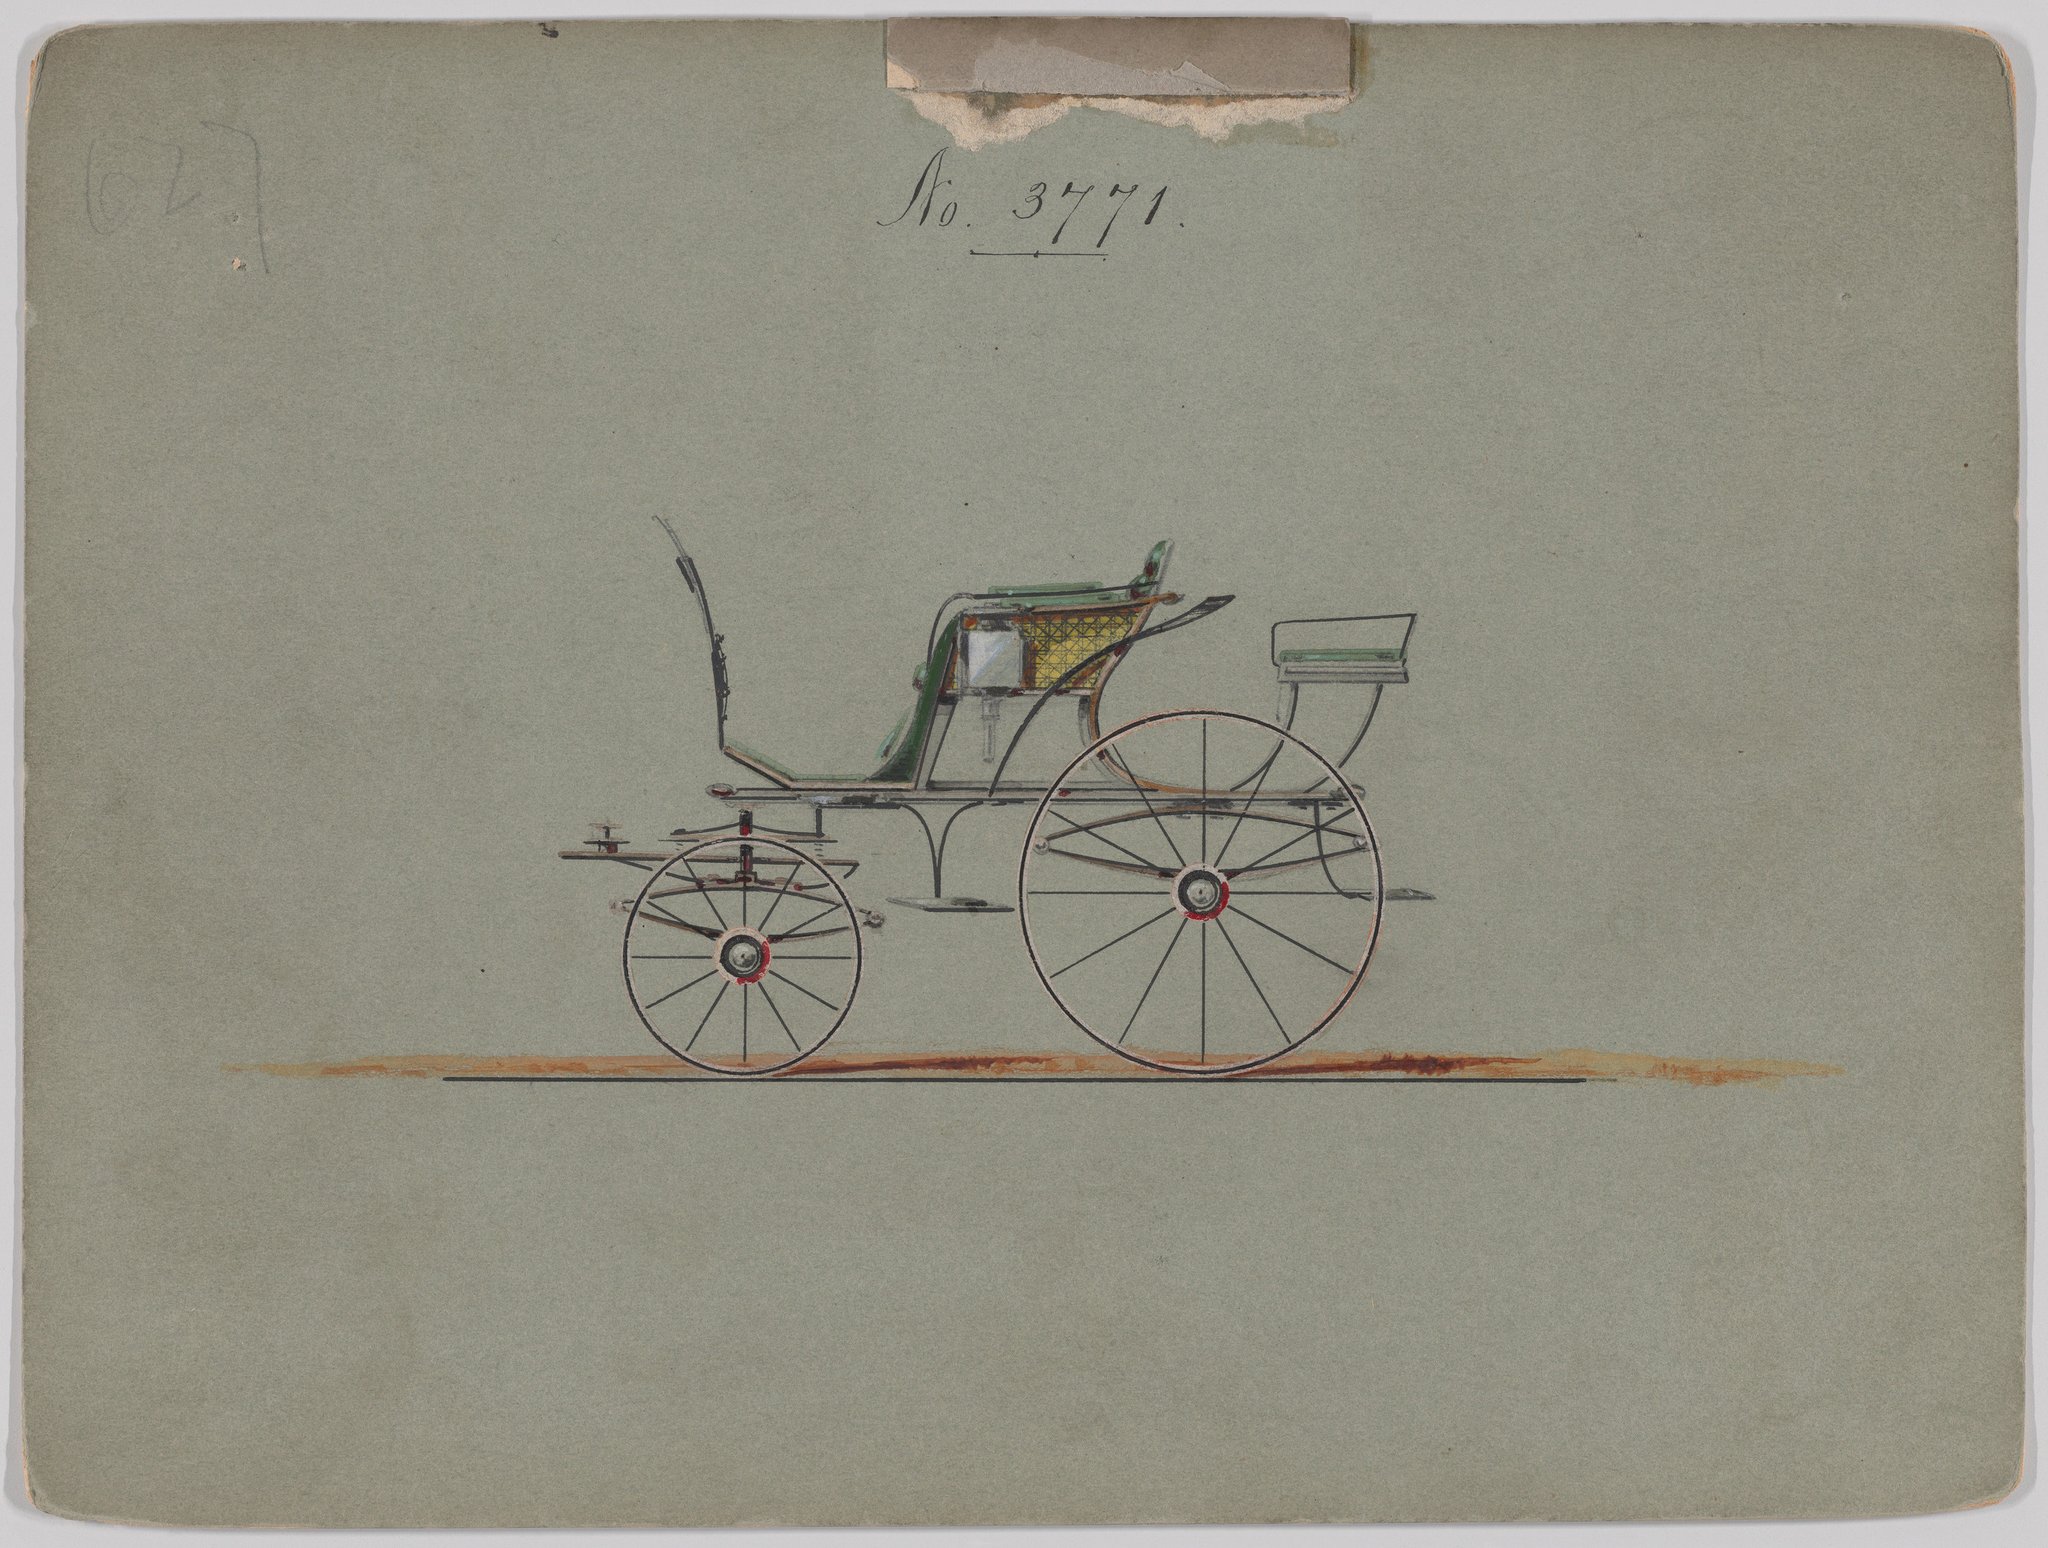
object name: drawing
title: Design for Pony Phaeton, no. 3771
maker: brewster & co.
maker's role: manufacturer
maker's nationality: american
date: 1882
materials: gouache, gum arabic, ink, watercolor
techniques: pen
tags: carriages